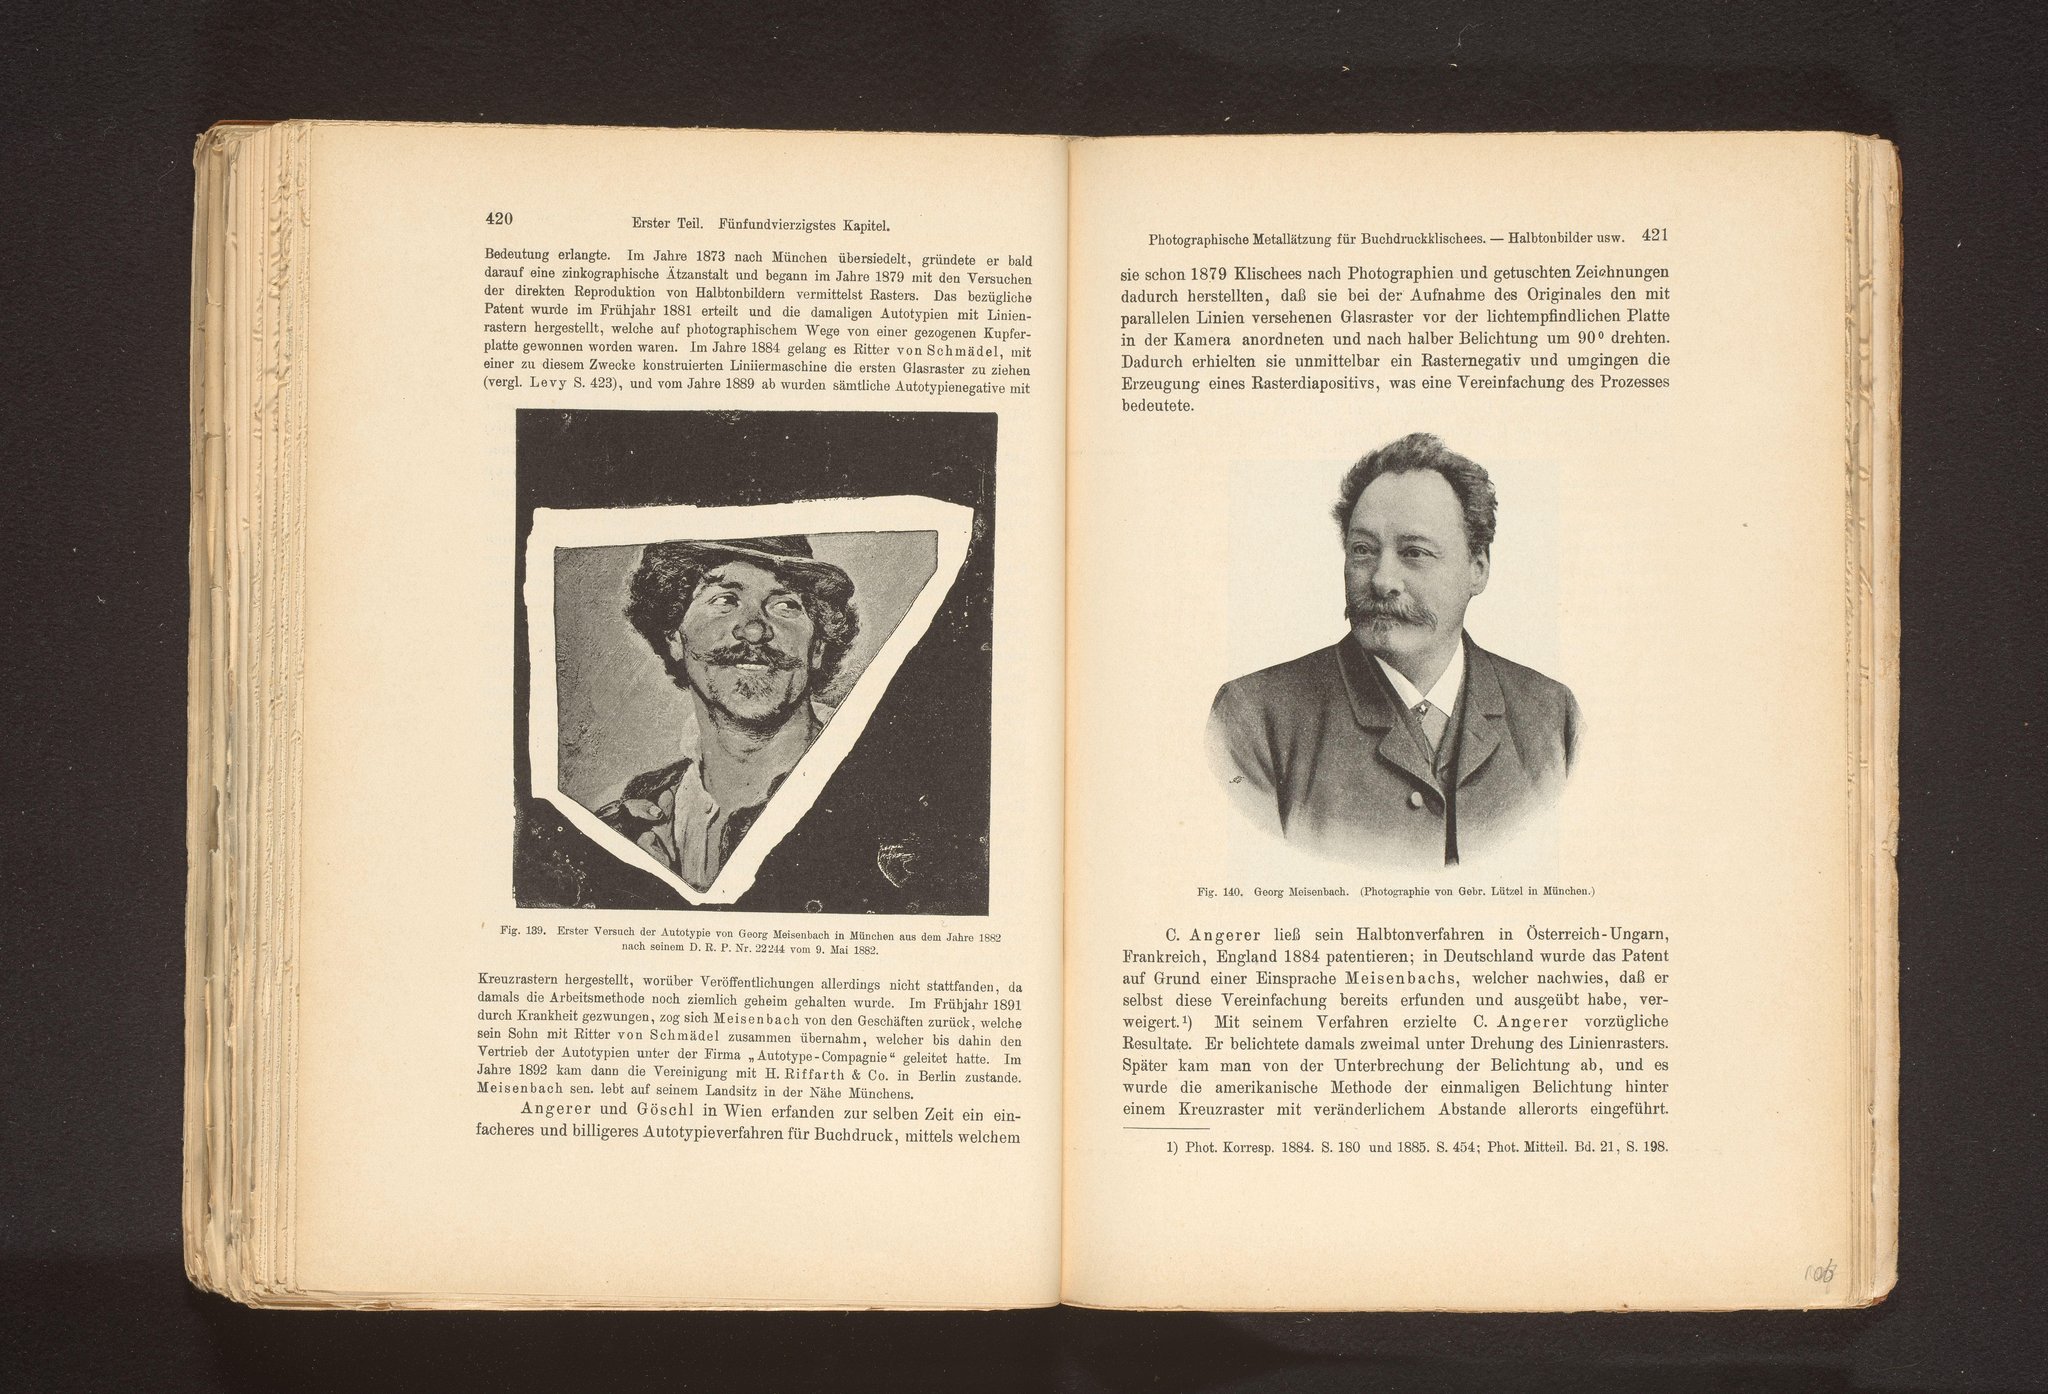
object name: photomechanical print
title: Fotoreproductie van een schilderij, voorstellende een portret van een onbekende man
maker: Anonymous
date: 1900-1905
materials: paper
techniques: autotype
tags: adult man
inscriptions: inscription: ‘Erster Versuch (...) 1882.’, number: ‘Fig. 139.’